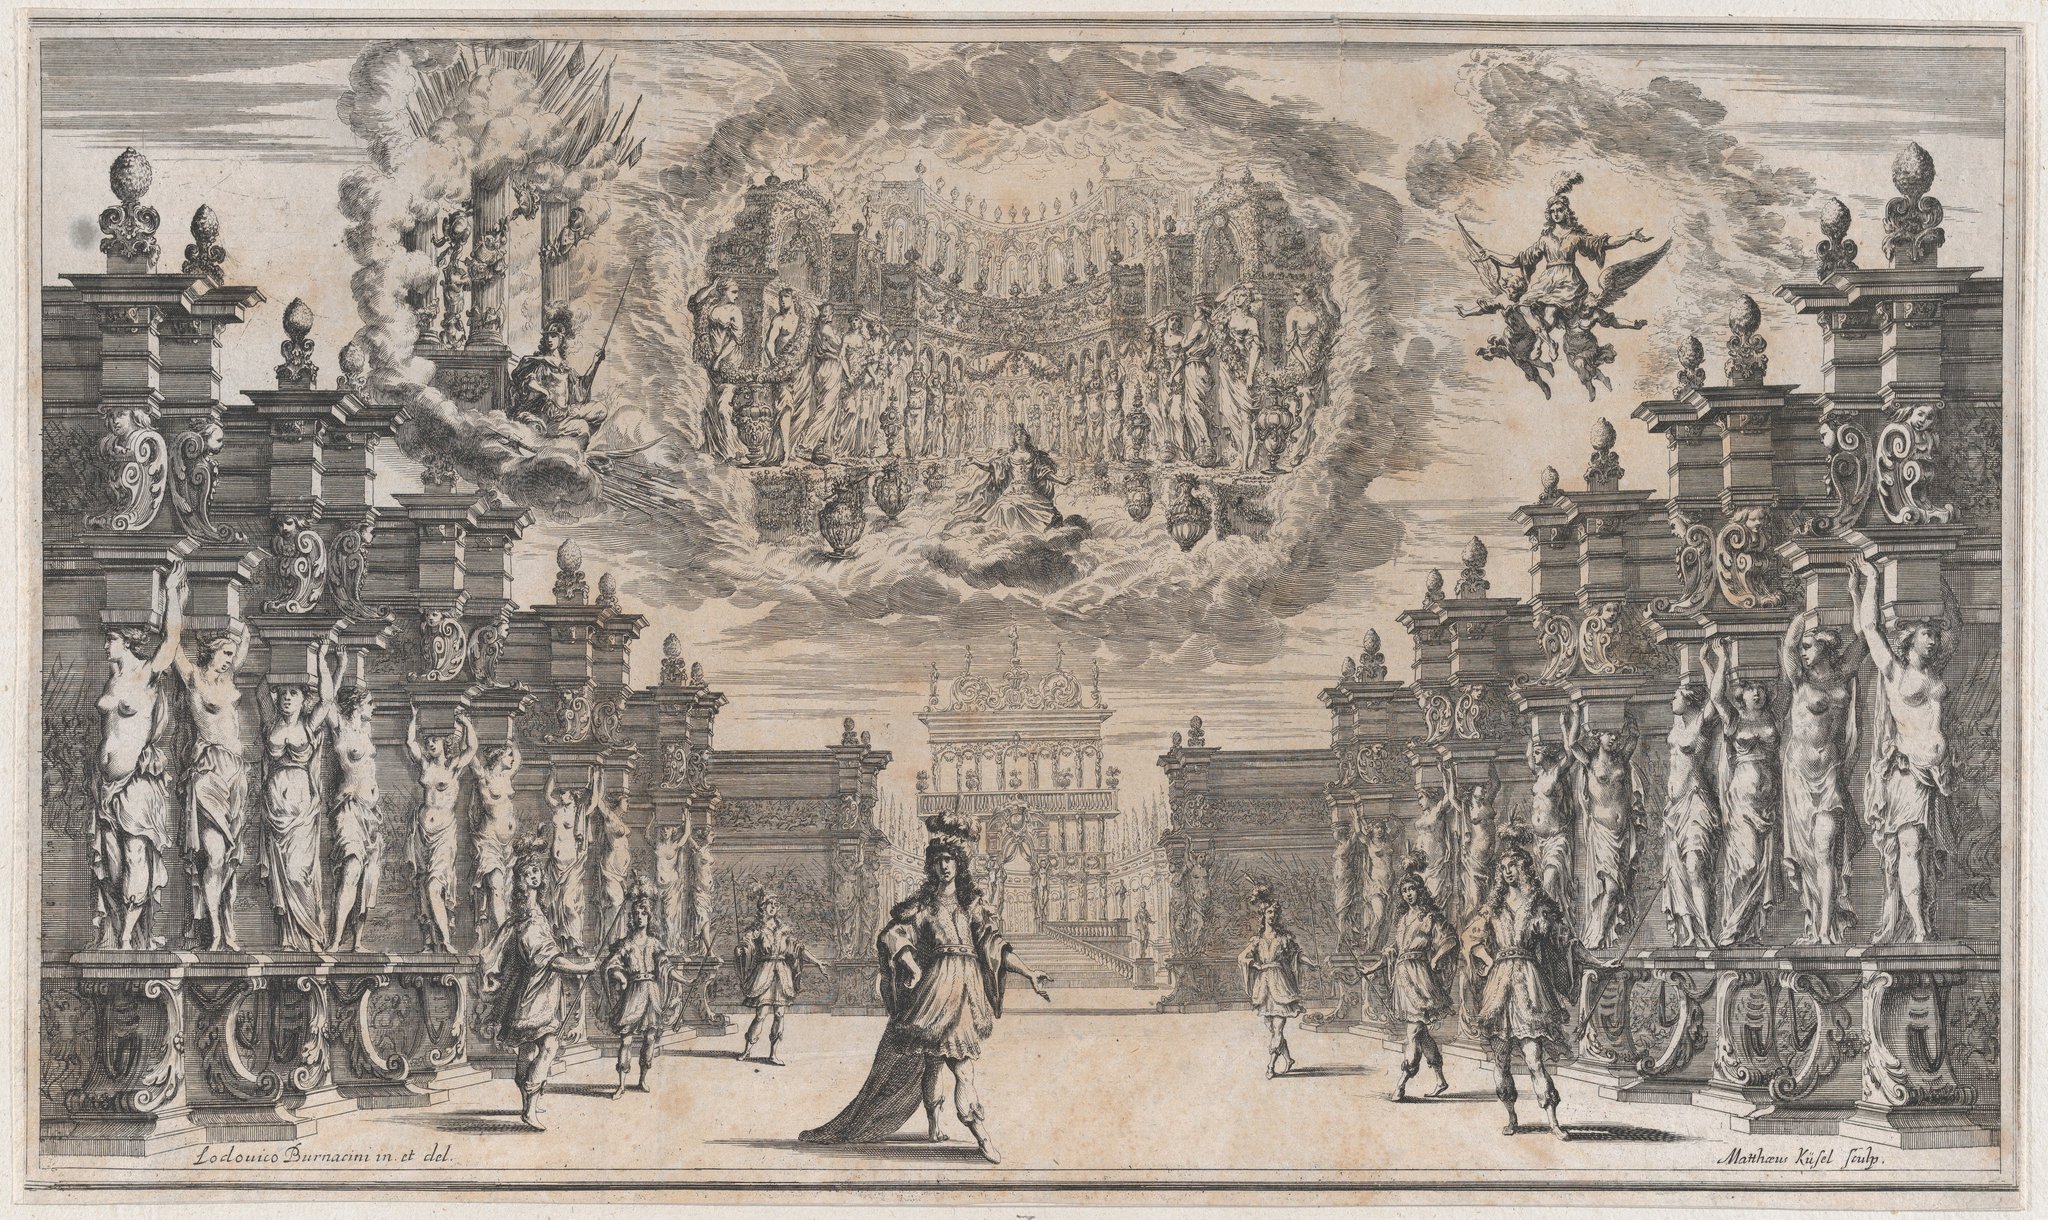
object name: print, fete, ornament architecture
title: Courtyard of a palace with a man standing at center surrounded by attendants; above, a vision of a woman in a similar scene; set design from 'Il Pomo D'Oro'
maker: mathäus küsel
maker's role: artist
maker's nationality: german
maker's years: 1621-1682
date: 1668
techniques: etching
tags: palaces,courtyards,men,women